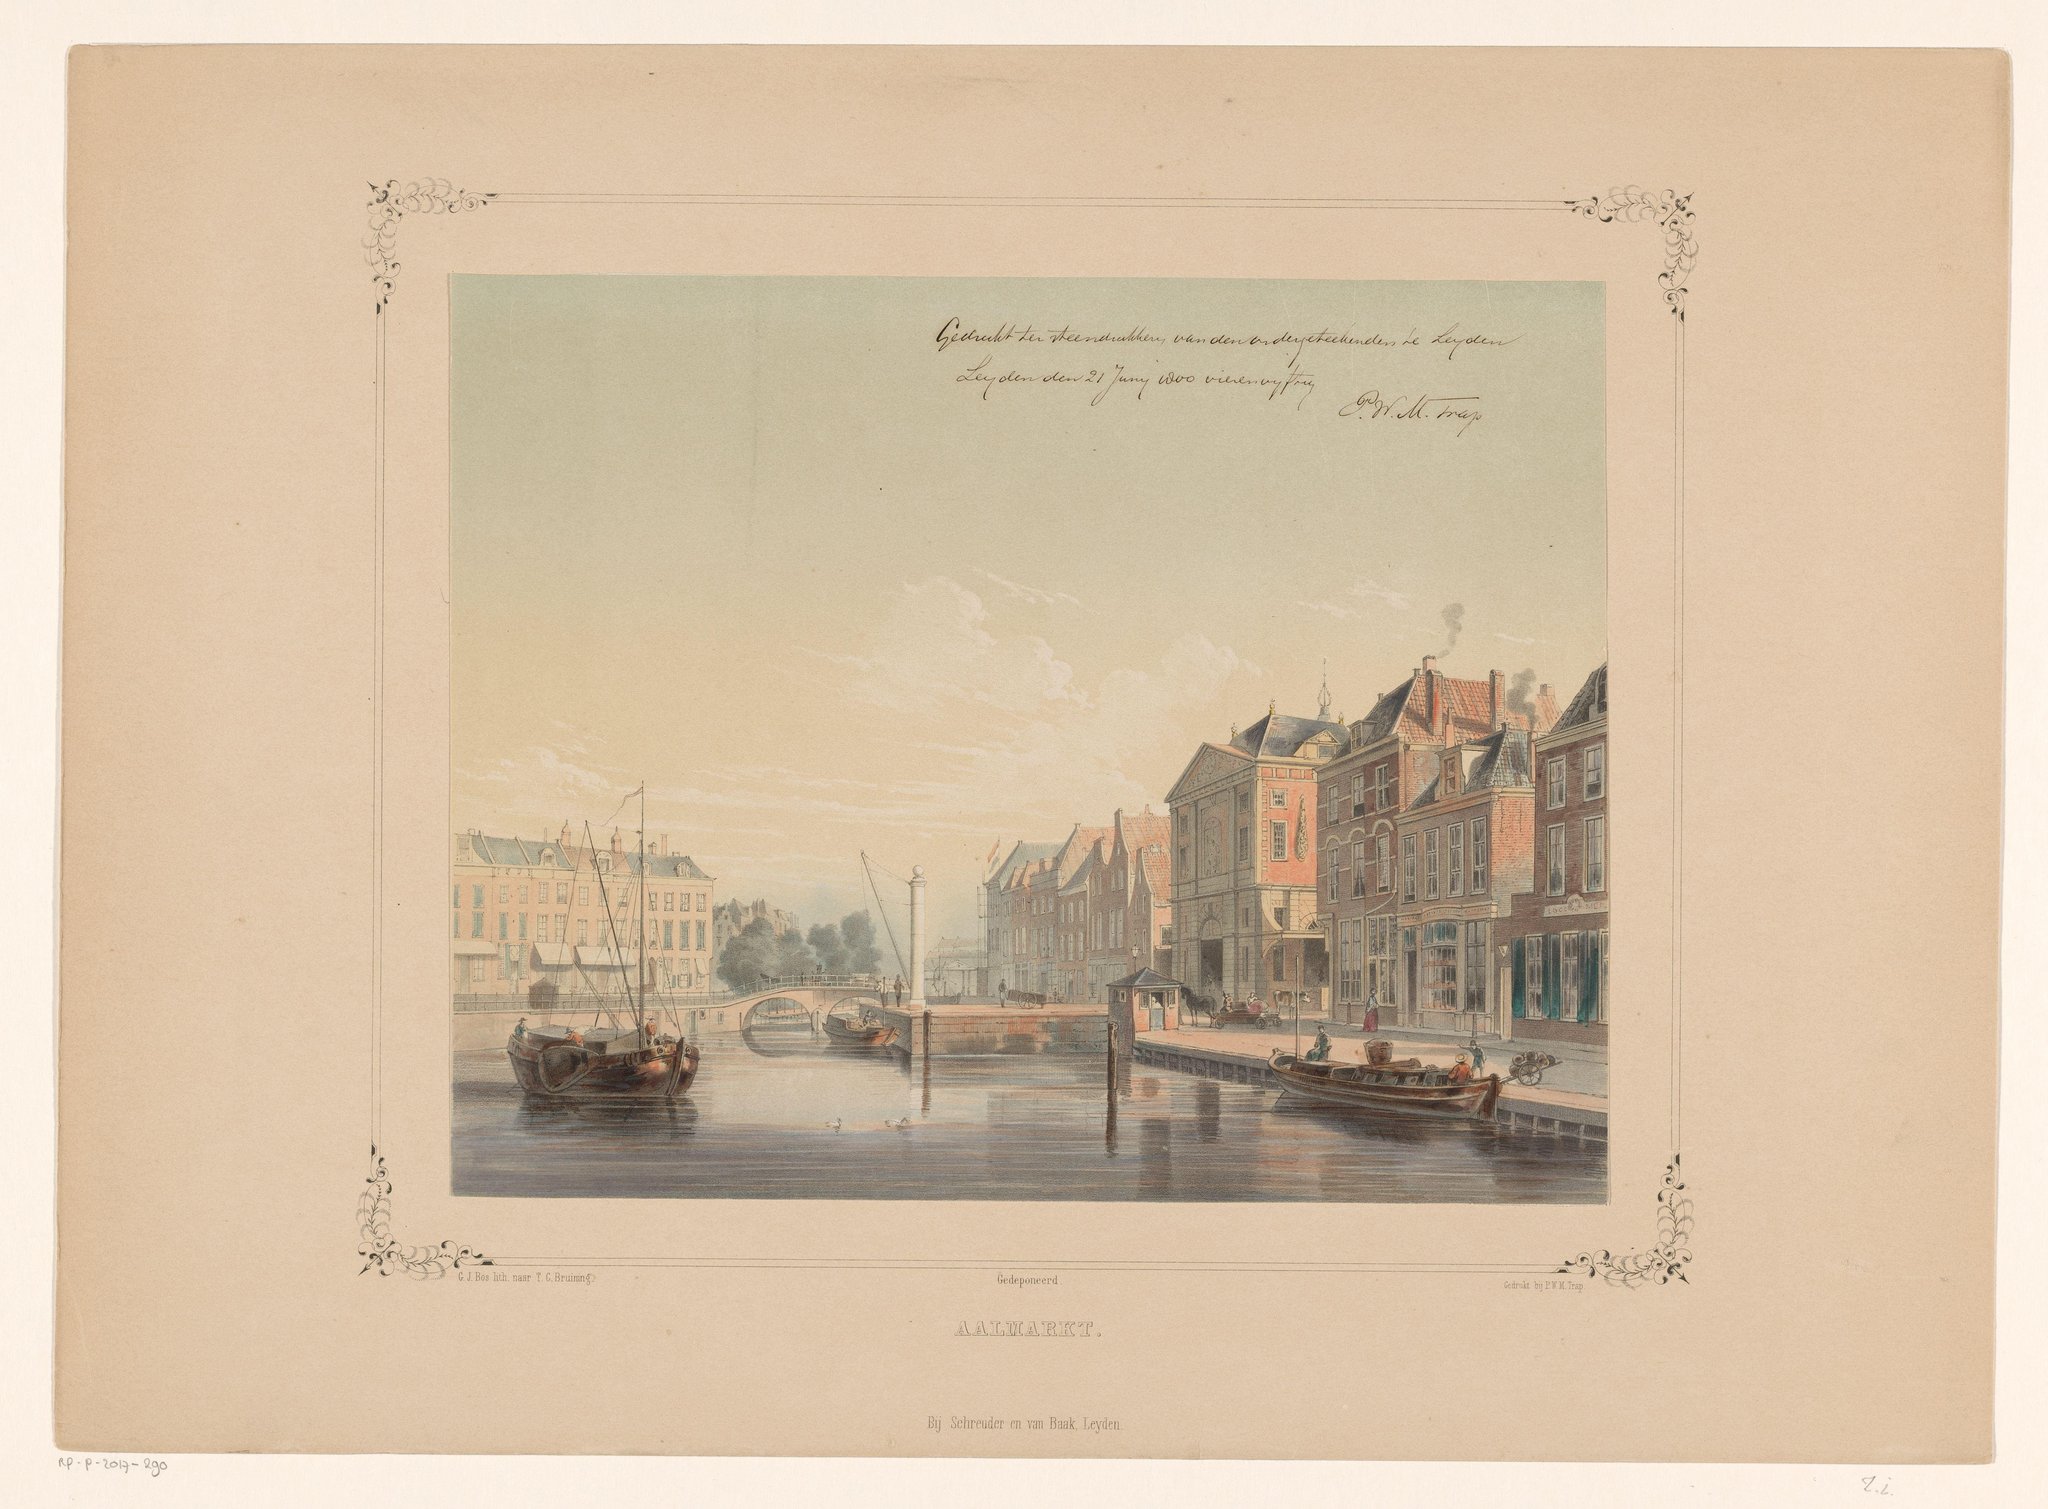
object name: print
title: Aalmarkt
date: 1854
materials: paper, watercolor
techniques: lithograph, hand coloring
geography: leiden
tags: canals, waters (in city) (+ city(-scape) with figures, staffage), leiden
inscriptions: : ‘Gedeponeerd.’, : ‘Gedrukt ter steendrukkerij van den ondergetekenden te Leyden / Leyden den 21 Juny 1800 vierenvijftig / P.W.M. Trap’